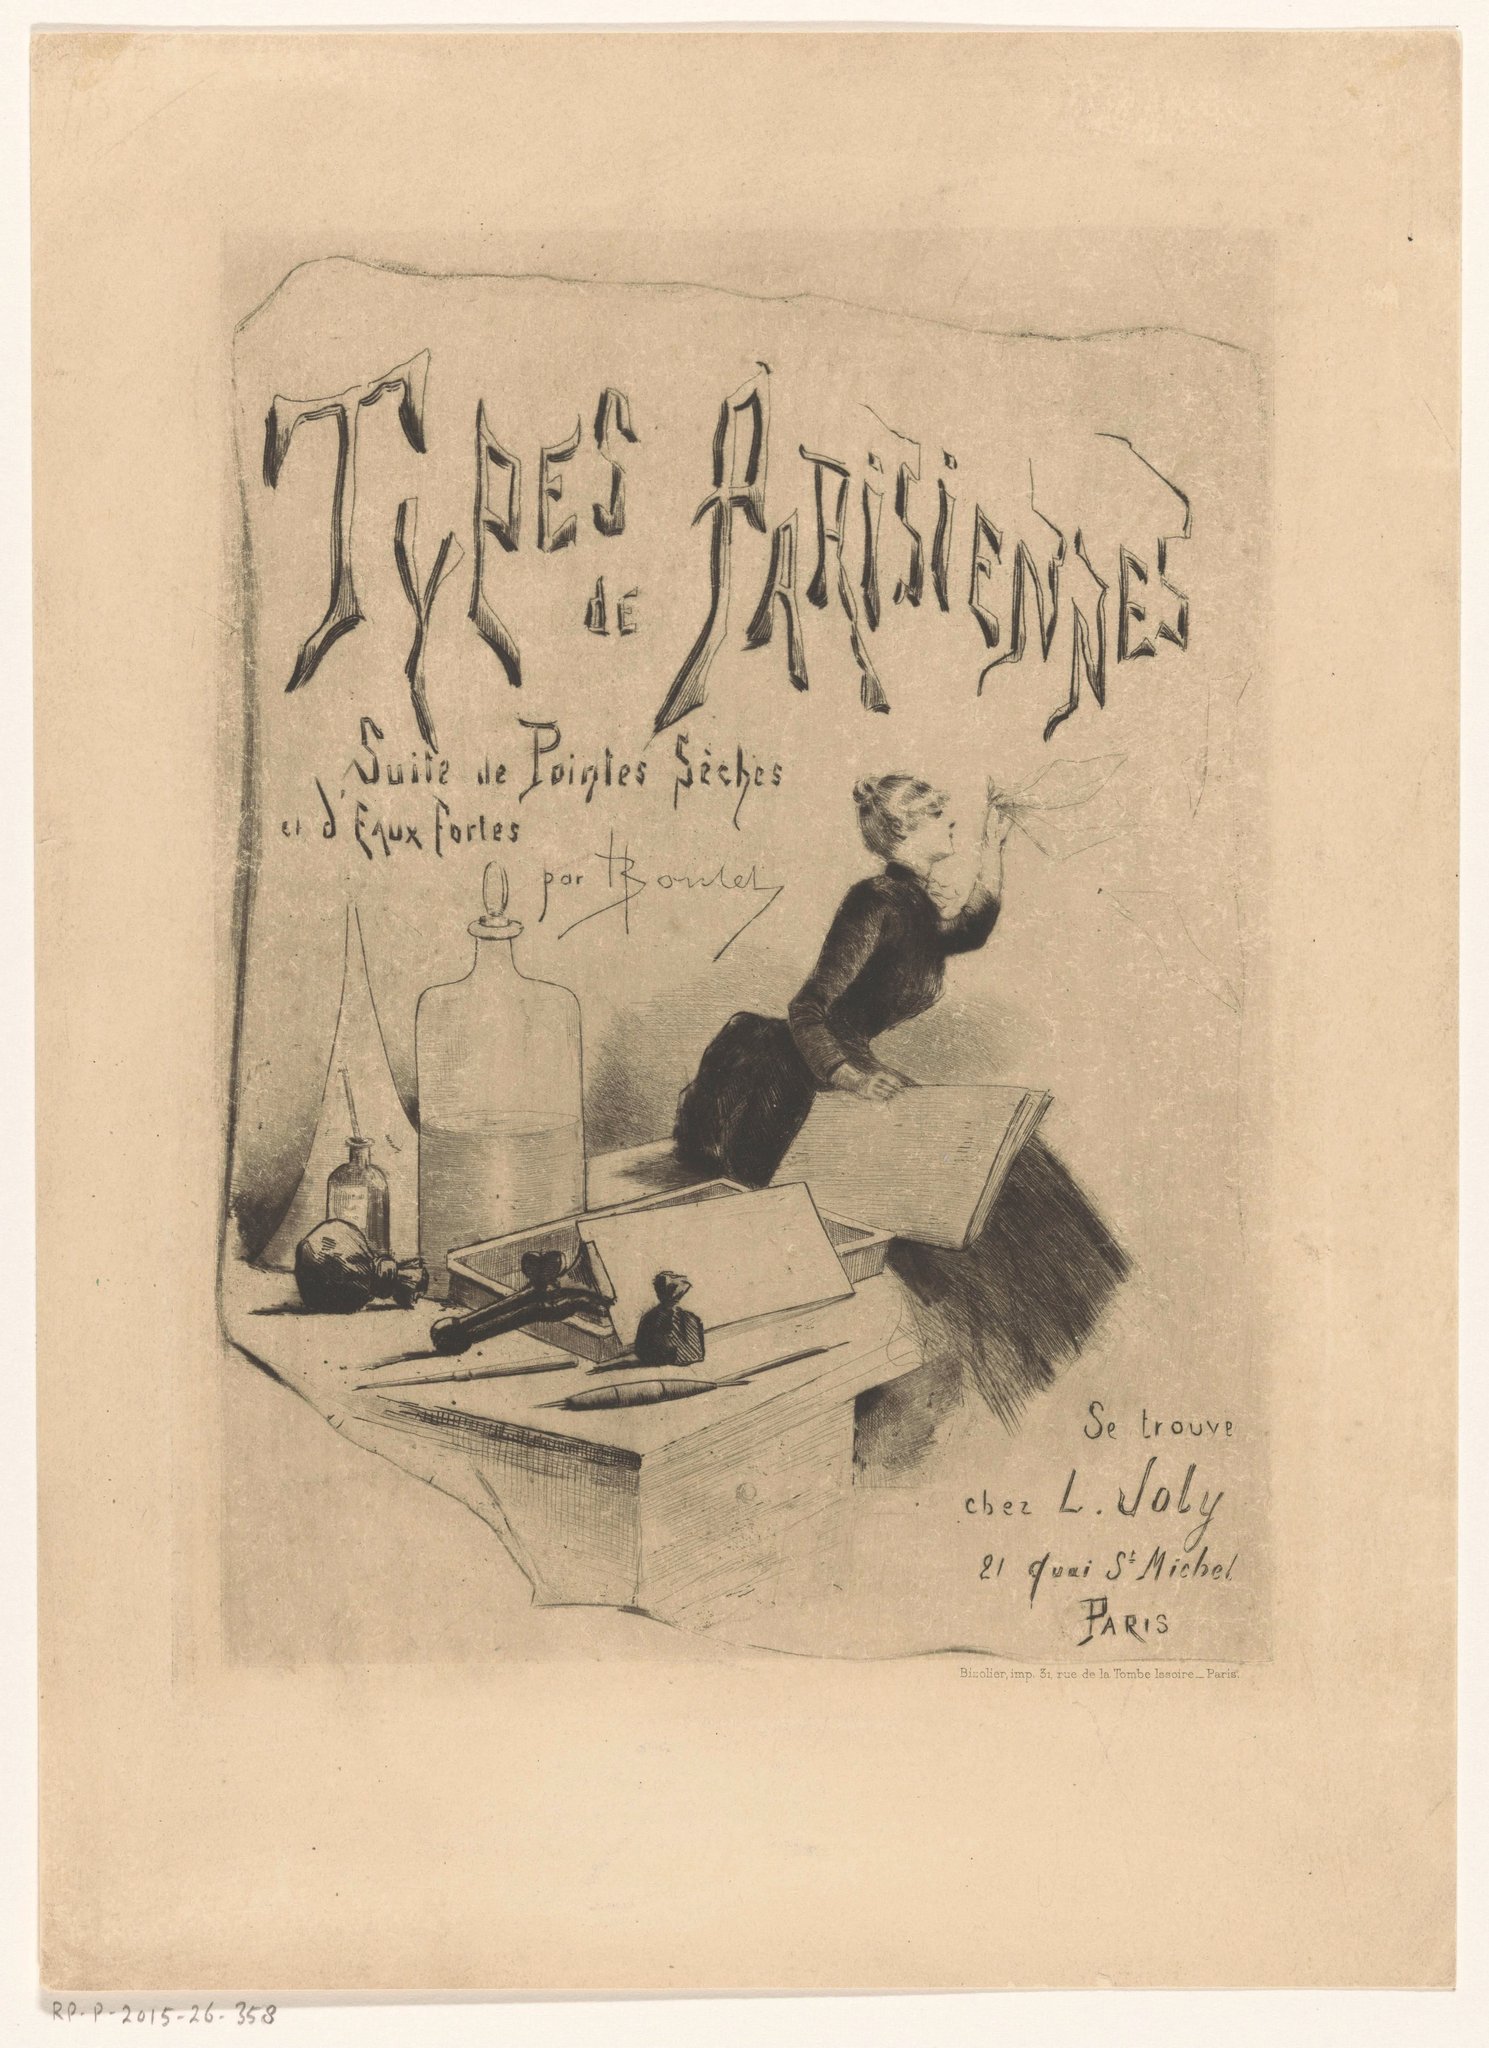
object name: print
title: Materialen en instrumenten van een prentmaker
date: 1885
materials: paper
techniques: drypoint, intaglio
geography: paris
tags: artist at work, in his workshop (+ graphic arts), tools, implements of graphic artist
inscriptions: collector's mark: Lugt 4779, collector's mark: Lugt 2228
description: Op de hoek van een tafel liggen onder andere etsnaalden, een inkttampon en een etsplaats voor een fles met etswater. In de achtergrond een vrouw met een portfolio.